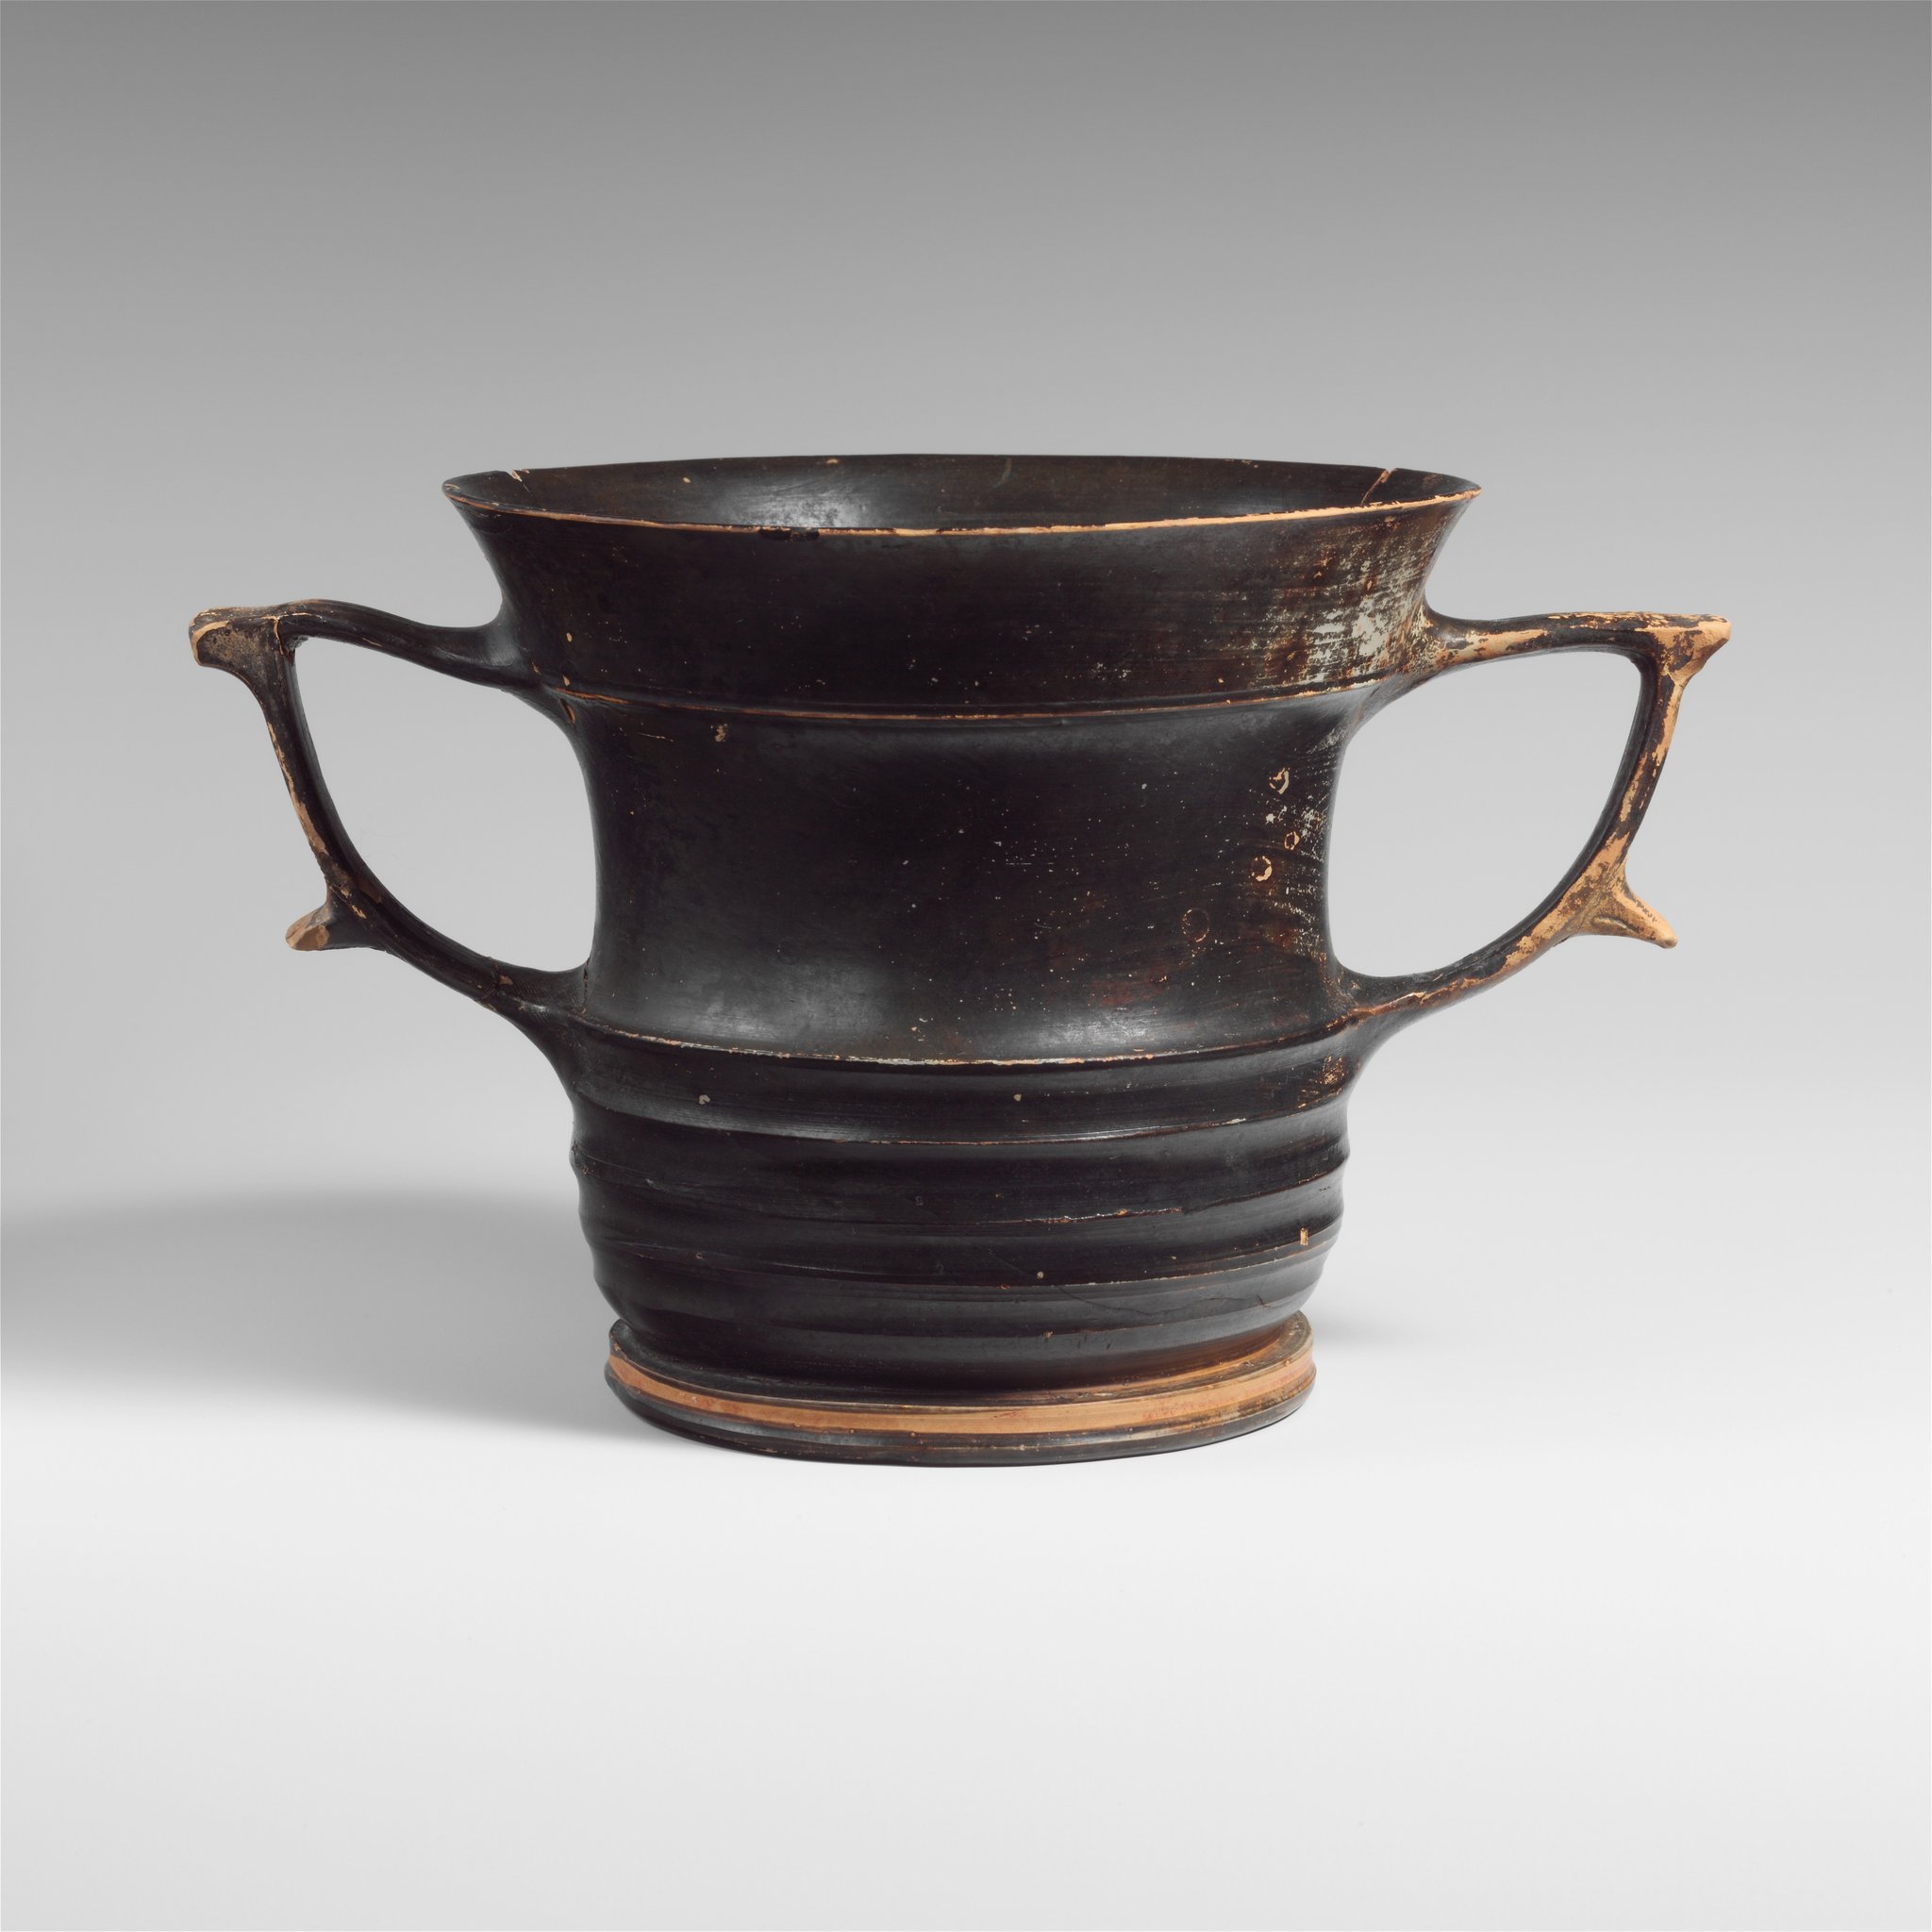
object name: kantharos, karchesion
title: Terracotta kantharos: karchesion (deep cylindrical drinking cup)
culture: greek, attic or boeotian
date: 400-301 BCE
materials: terracotta